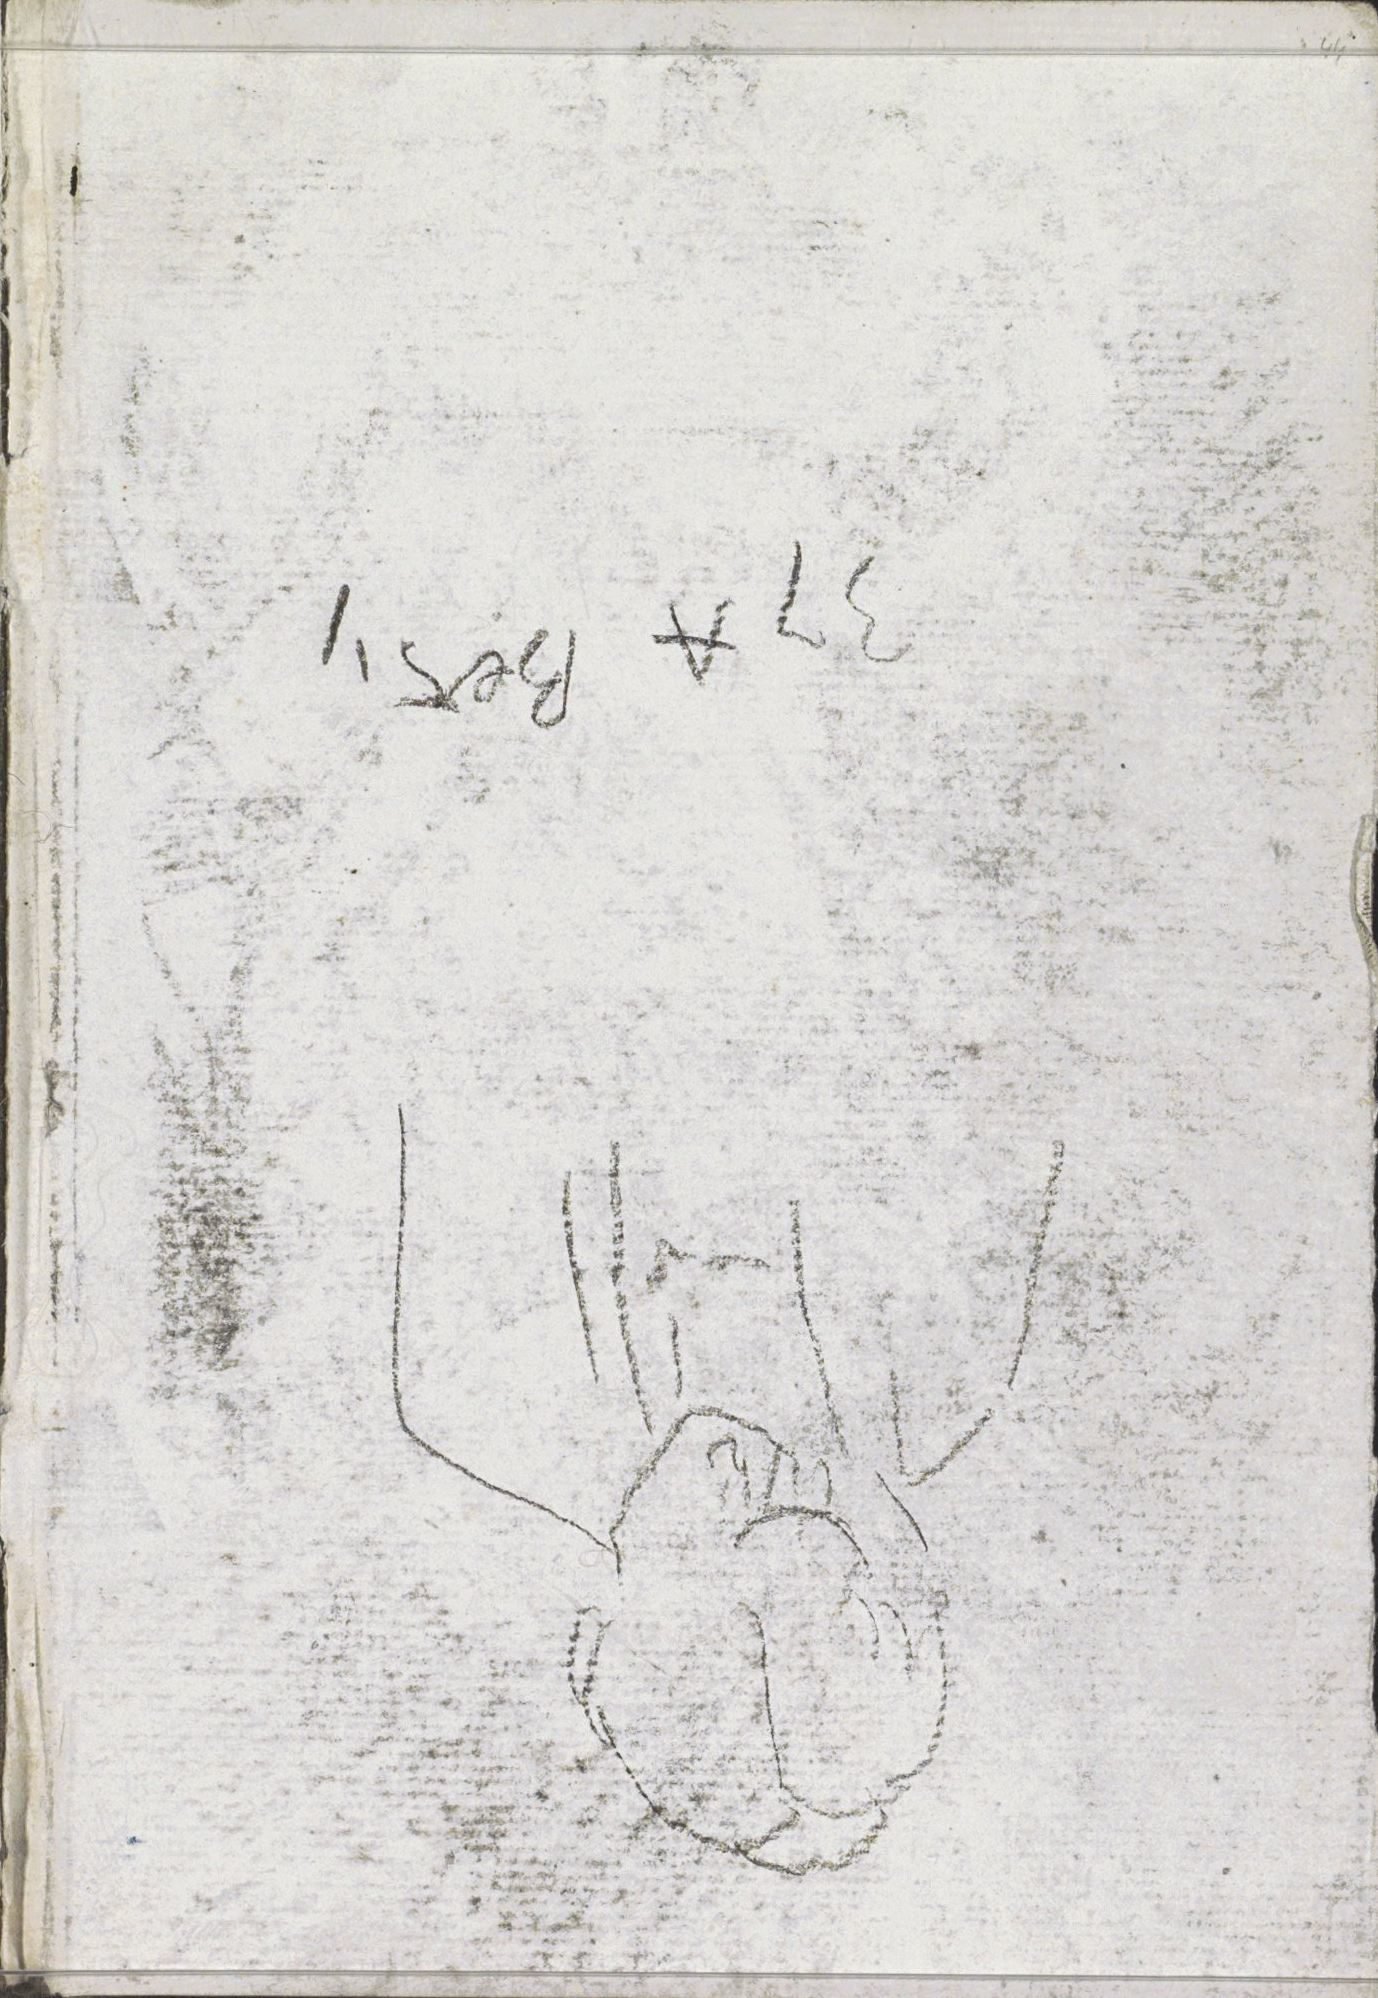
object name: sketchbook leaf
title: Vrouw, naar beneden kijkend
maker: isaac israels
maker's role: draughtsman, painter, print maker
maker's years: 1865-1934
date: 1875-1934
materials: chalk, paper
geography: the hague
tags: adult woman, looking downwards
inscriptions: annotation: ‘37A Be[...]’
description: Pagina 44, achterste schutblad, uit schetsboek XLIV met 43 pagina's.